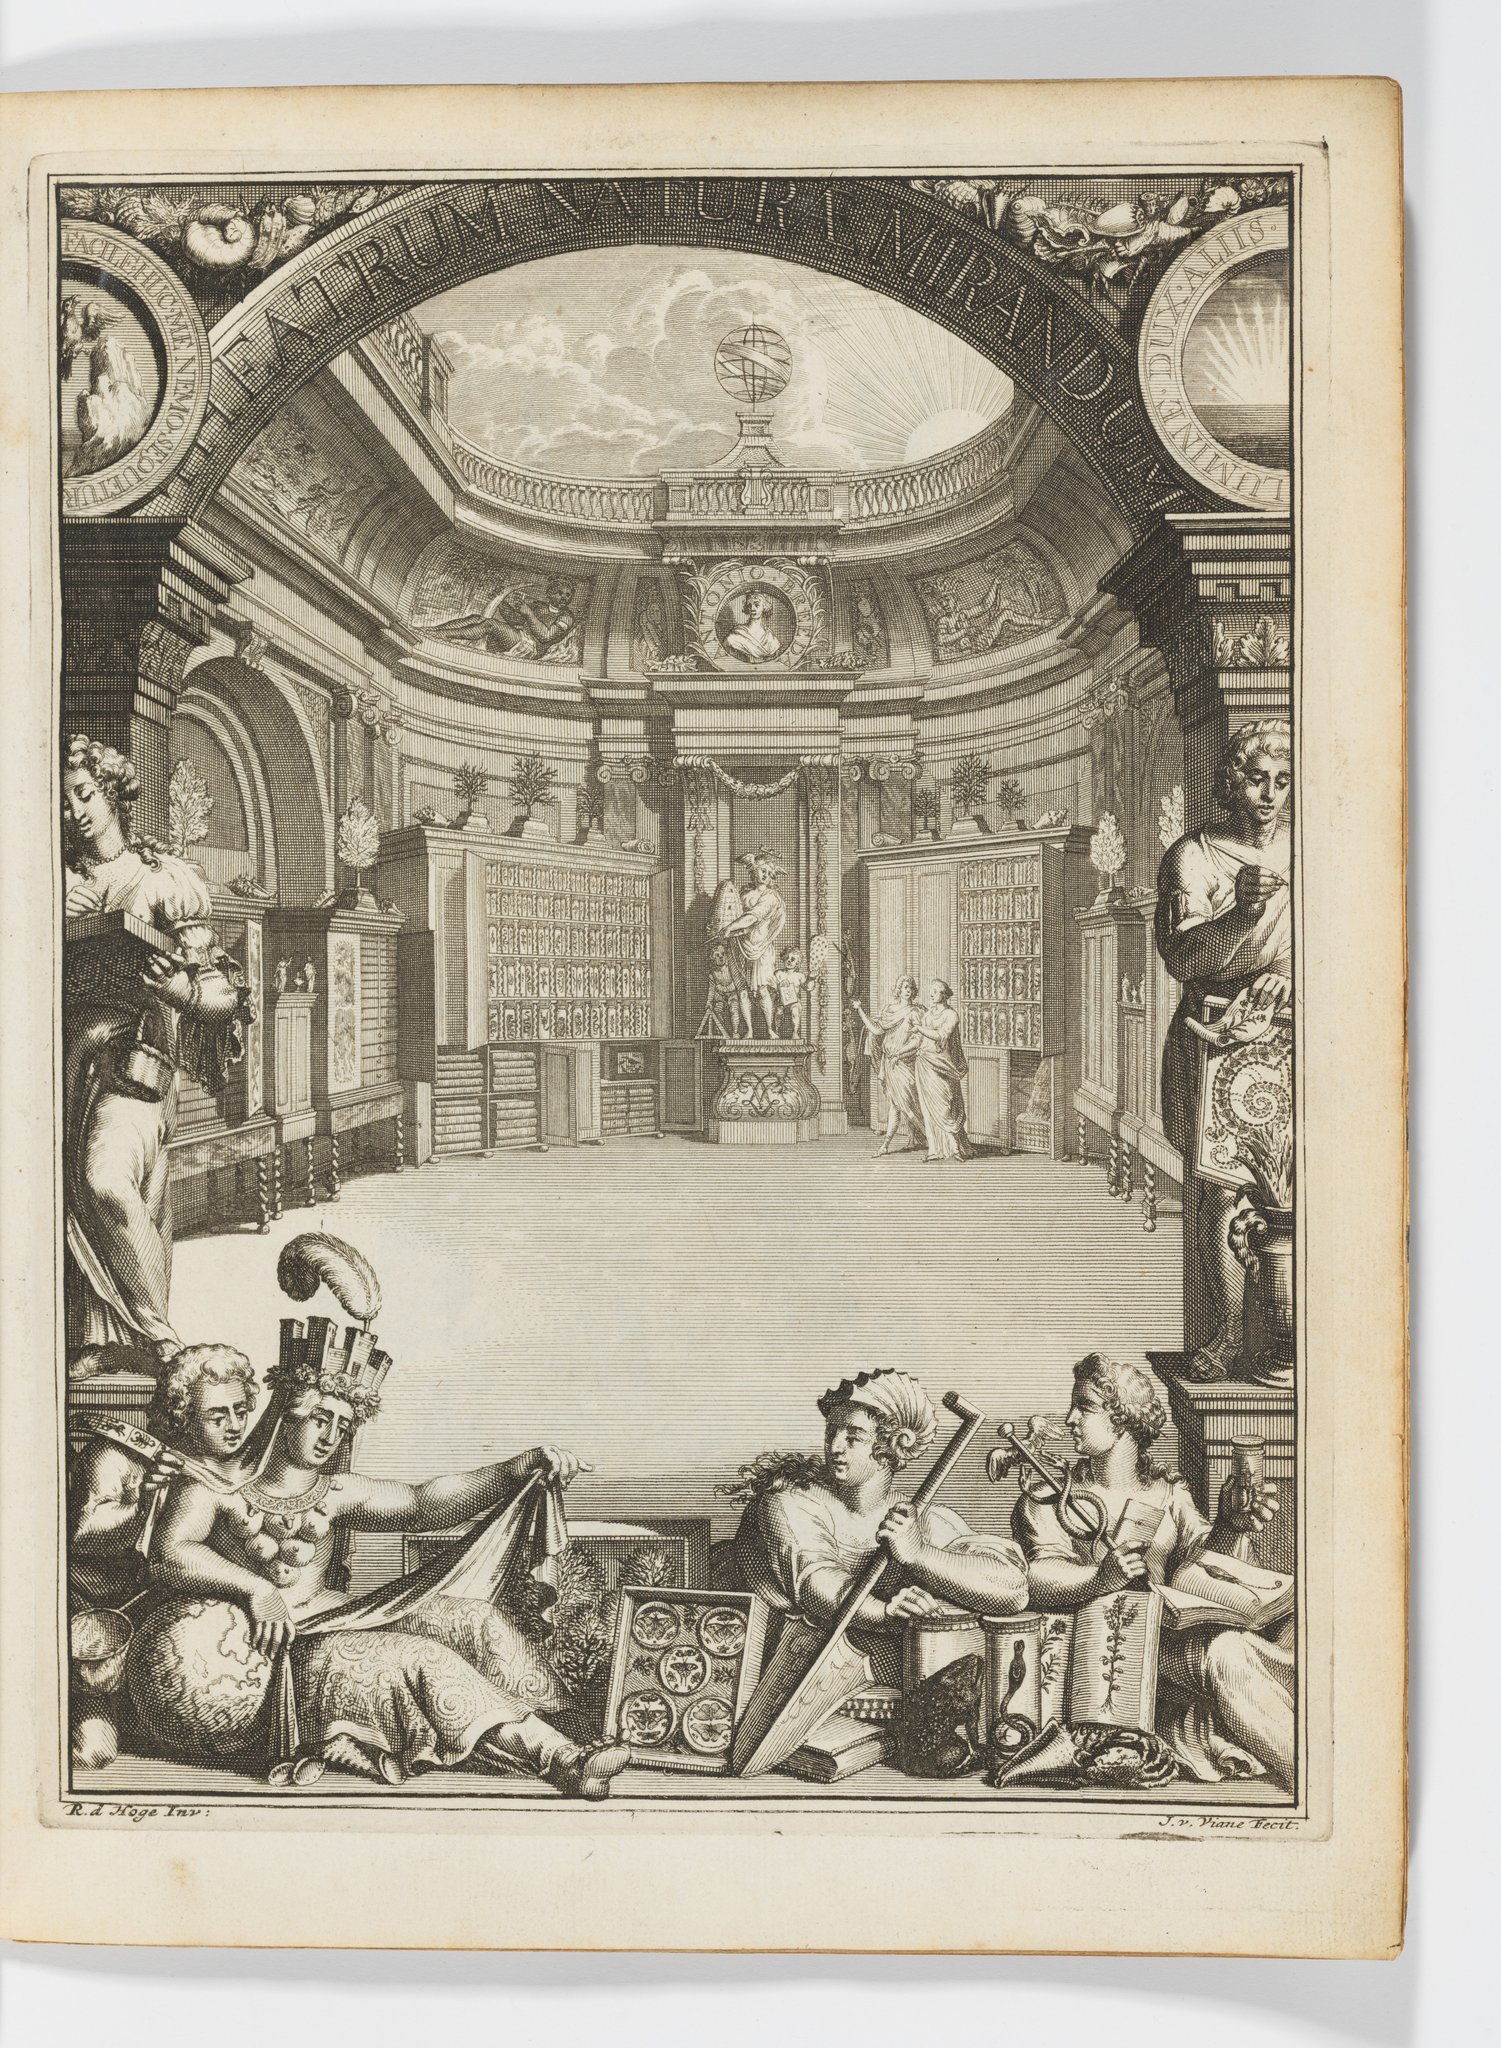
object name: book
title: Wondertooneel der Nature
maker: levinus vincent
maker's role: author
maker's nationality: dutch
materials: parchment